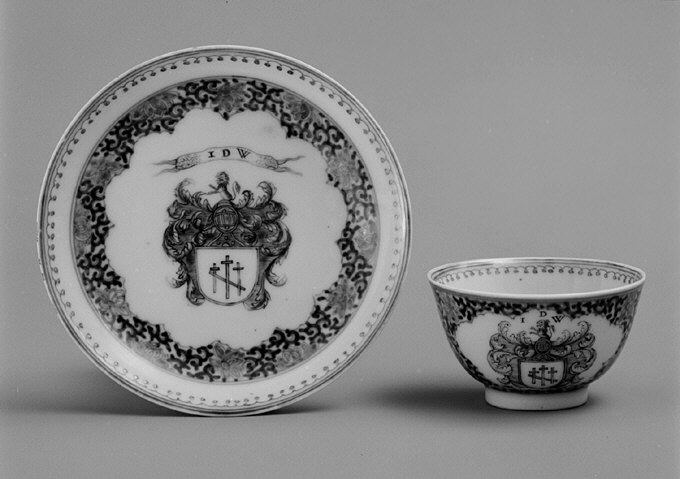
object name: teabowl and saucer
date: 1715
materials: hard paste porcelain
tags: coat of arms